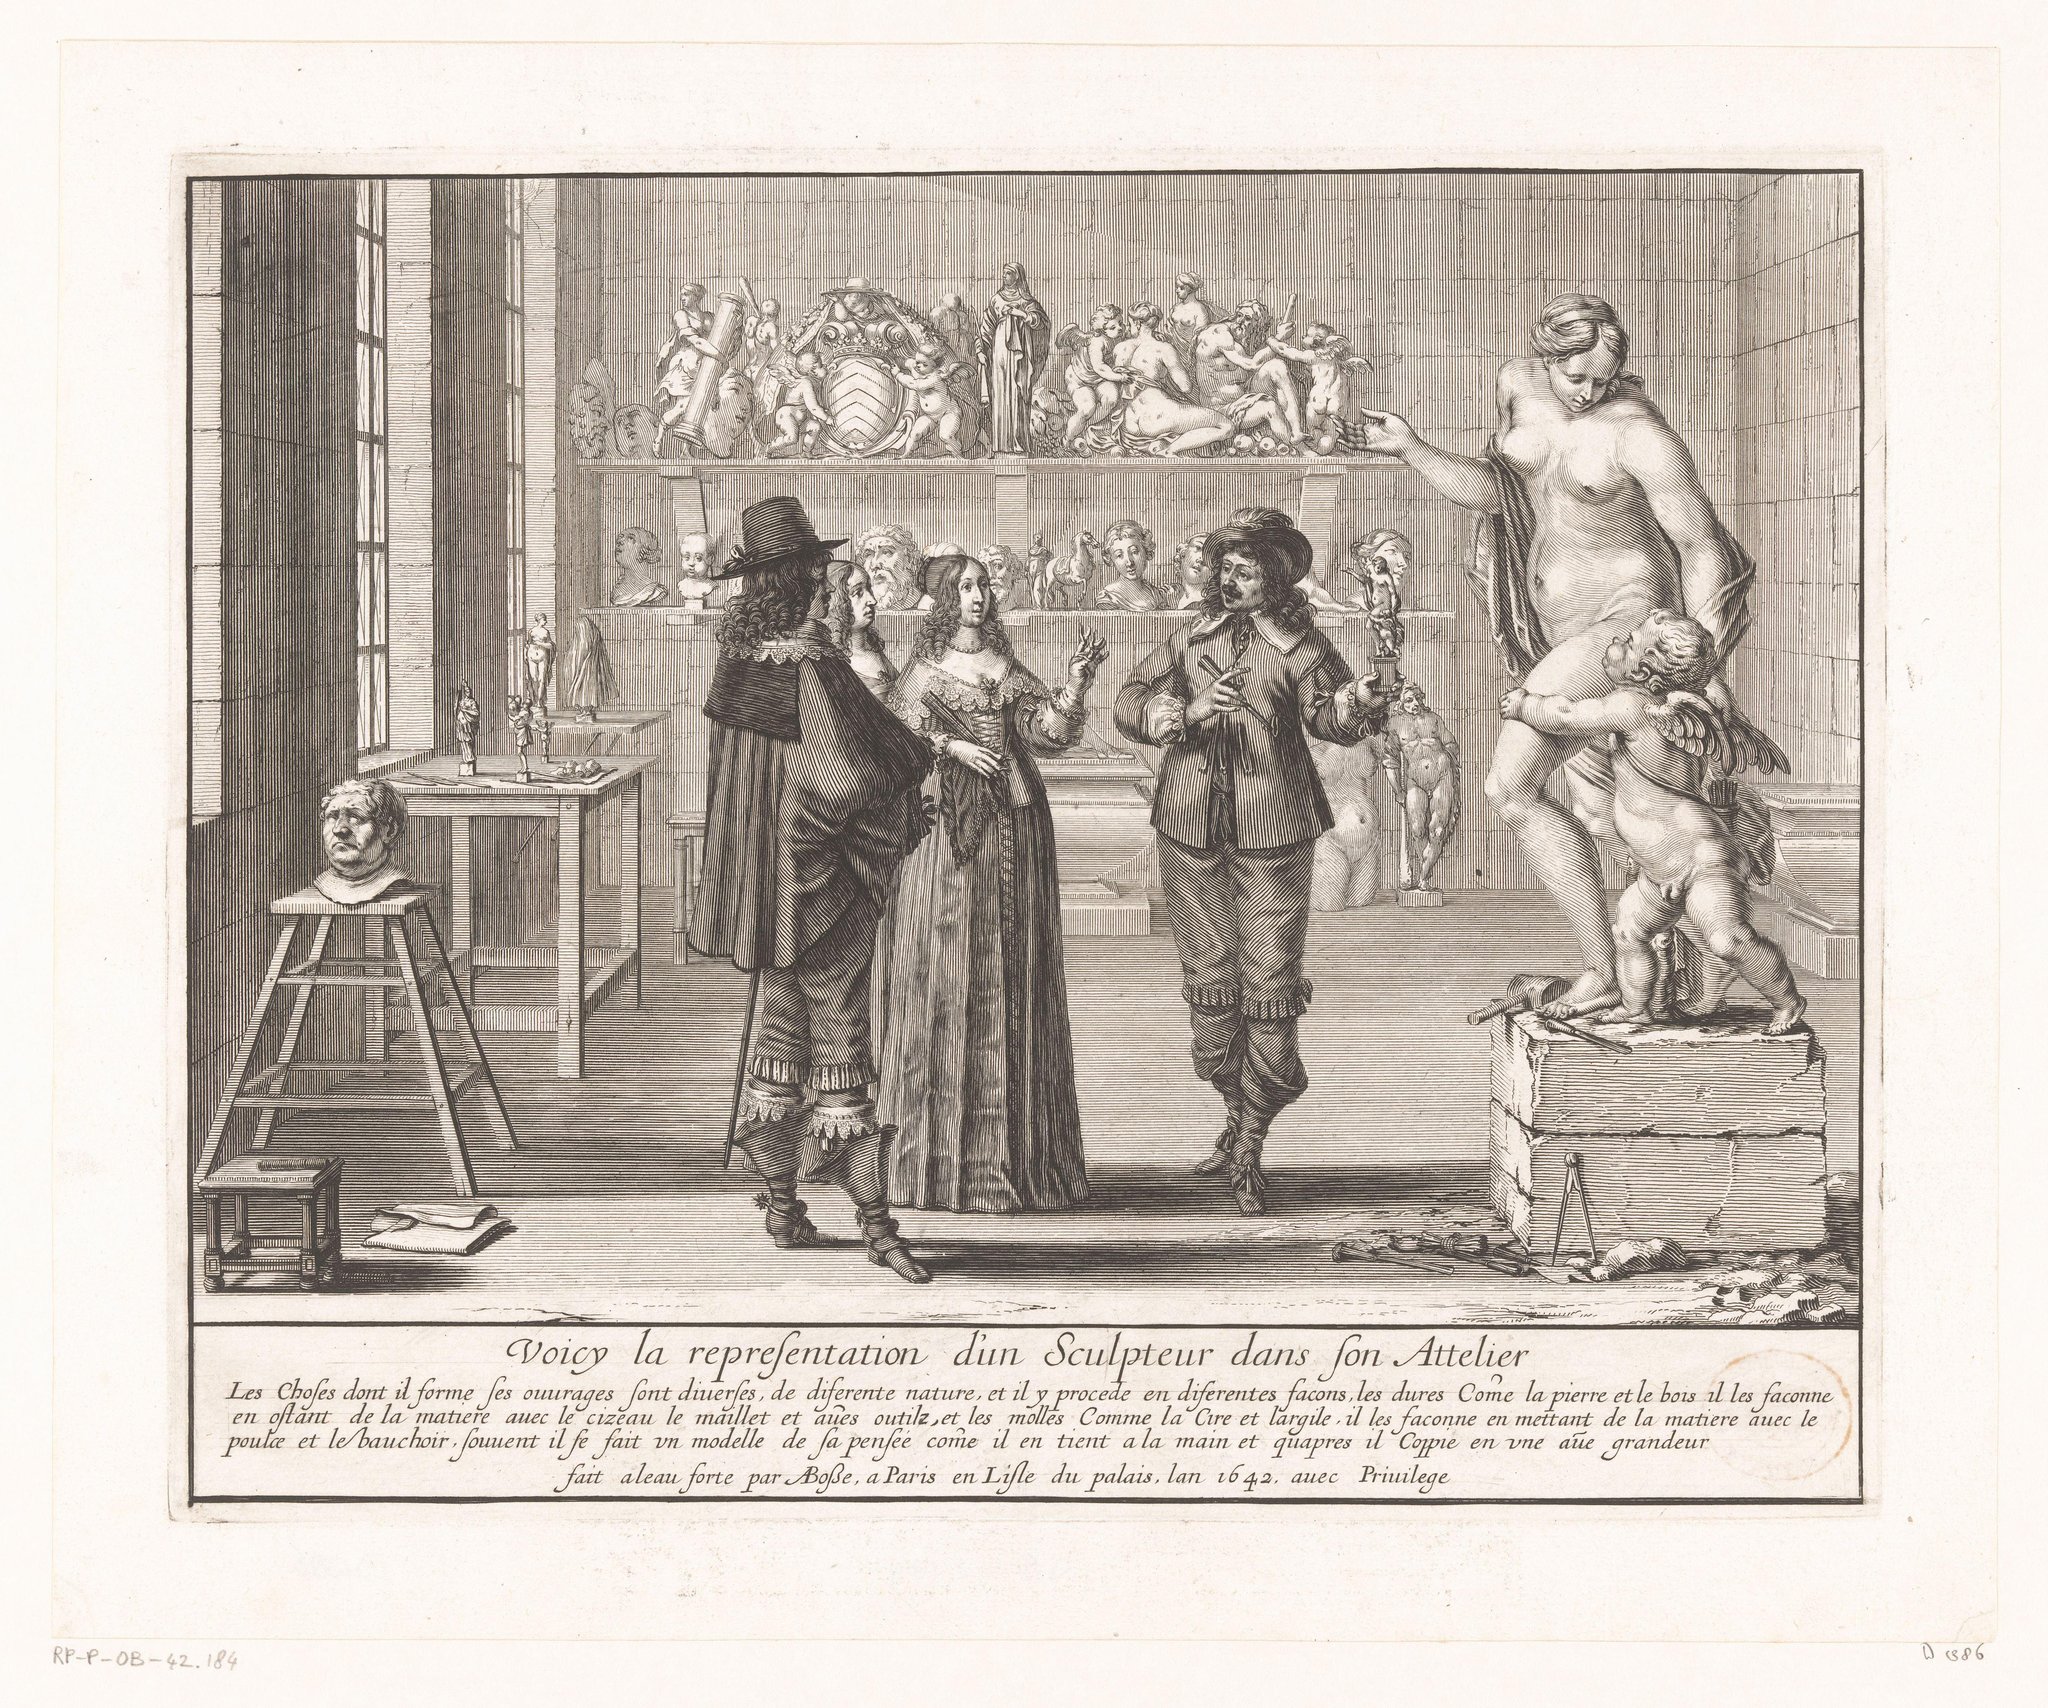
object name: print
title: Beeldhouwer in zijn atelier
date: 1642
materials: paper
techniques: etching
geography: paris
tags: piece of sculpture, reproduction of a piece of sculpture, sculptor in non-work situation, workshop, studio of the artist (in general), patron (or client) visiting the artist, tools, implements of sculptor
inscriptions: collector's mark: Lugt 240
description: 'Voici la réprésentation d'un sculpteur dans son Atelier', meldt de ondertitel van de prent. Dat het om een beeldhouwersatelier gaat is te zien aan de 'bok' links bij het venster, waarop een gebeeldhouwde kop staat en aan de talloze kleine modellen op de planken aan de muur. De beeldhouwer zelf houdt een dergelijk model, ook wel bozzetto genaamd, in zijn hand. Het is de voorstudie van het beeld dat naast hem staat; waarschijnlijk toont hij het ter vergelijking aan zijn bezoekers, die heel goed de opdrachtgevers kunnen zijn.. Een beeldhouwwerk werd meestal in opdracht gemaakt. Als de opdrachtgever had besloten wat hij wilde, liet hij er een ontwerptekening van maken door een tekenaar of door de beeldhouwer zelf. Deze maakte daarna een model op kleine schaal in was of klei, dat hij ter goedkeuring aan zijn opdrachtgever toonde. Aan de hand van dit model werd het beeld in het groot uitgevoerd. Het ruwe werk, het hakken van de vorm uit de grove steen, werd aan assistenten overgelaten. De meester zelf hield zich alleen met het idee en de afwerking bezig. Het onderschrift van de prent van Bosse vertelt ons dat het model dat de beeldhouwer toont, er een naar eigen inventie is. Hij is dus niet zozeer uitvoerend- maar veeleer beeldend kunstenaar, en zo wordt hij ook afgebeeld. De tekst vertelt verder dat de beeldhouwer in hout, steen en was werkt en daarbij verschillende soorten gereedschap hanteert. Beitels, passer en de houten hamer heeft hij nodig gehad voor deze Venus en Amor in steen.